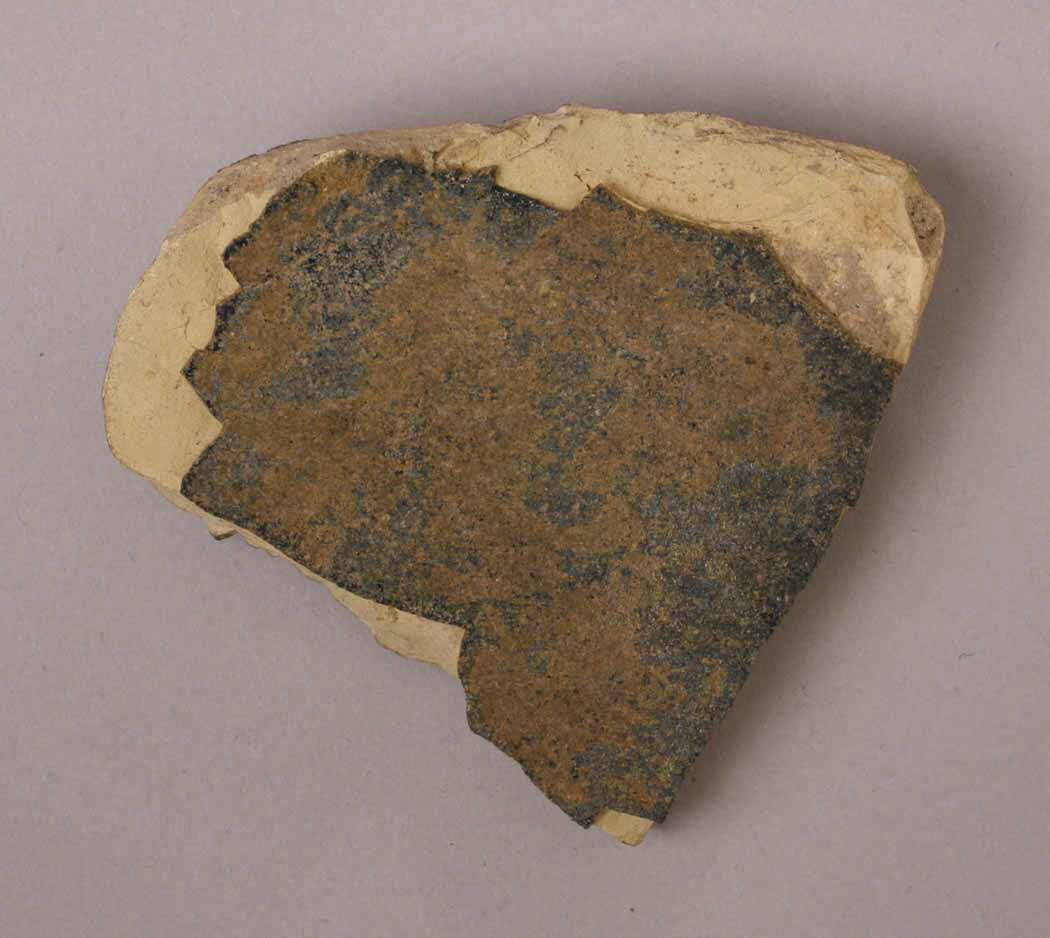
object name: fragment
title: Fragments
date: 801-900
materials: earthenware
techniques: glazing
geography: iraq